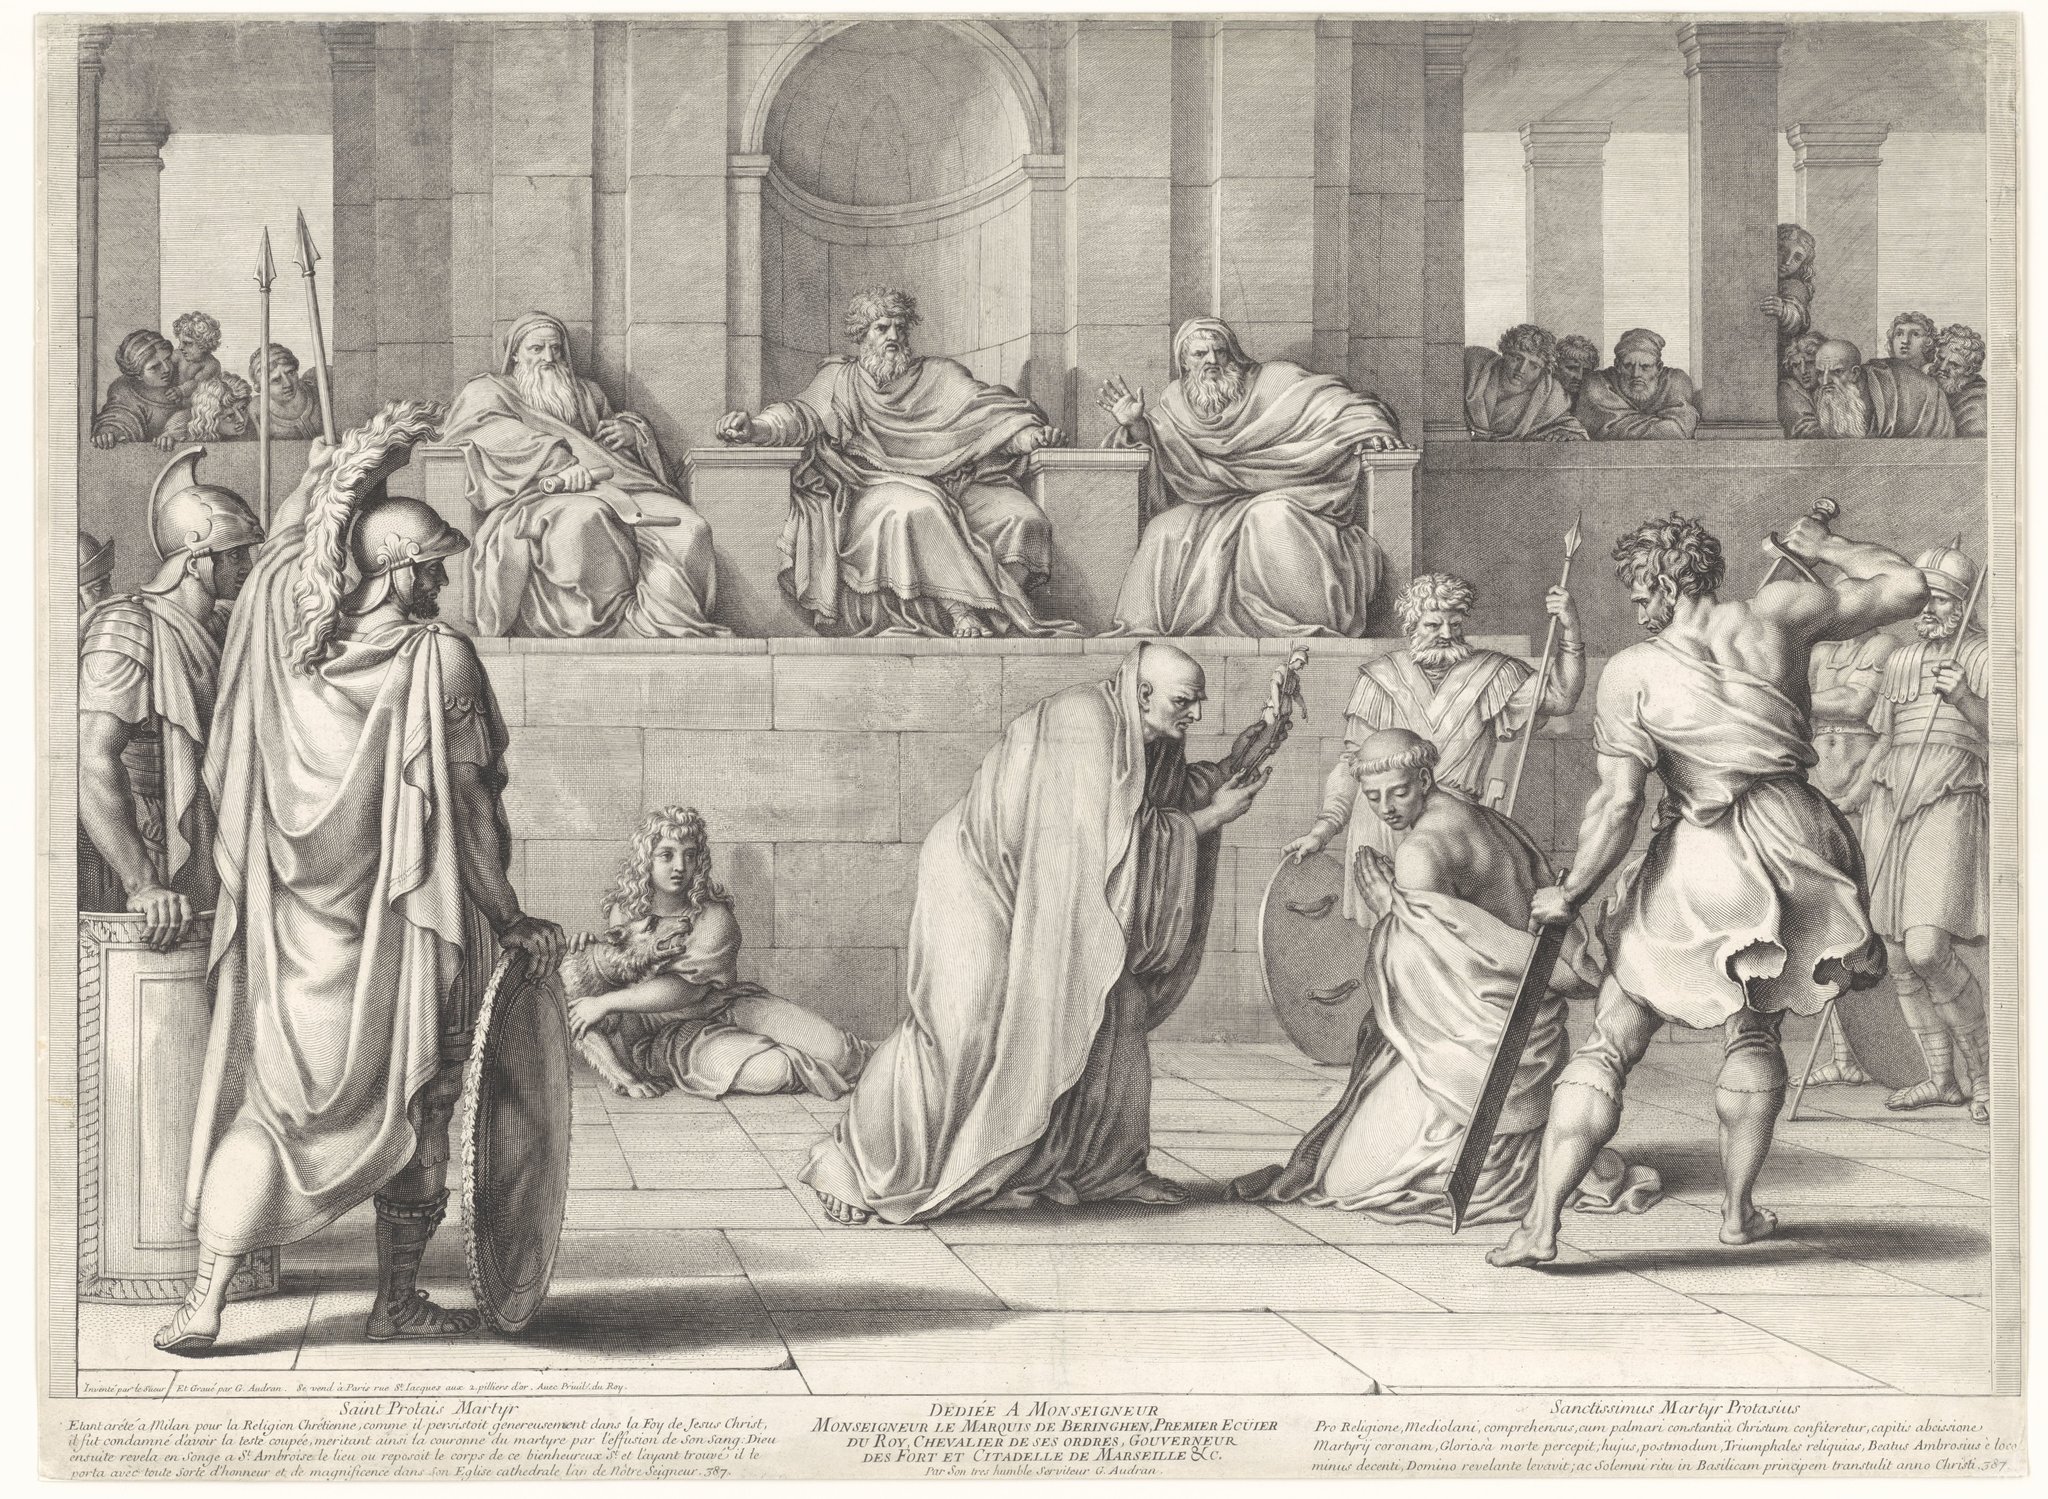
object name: print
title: Martelaarschap van H. Protasius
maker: gérard audran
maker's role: print maker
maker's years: 1640-1703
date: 1650-1703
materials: paper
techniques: engraving, etching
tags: the martyrs and deacons gervase and protase; possible attributes: sword, whip